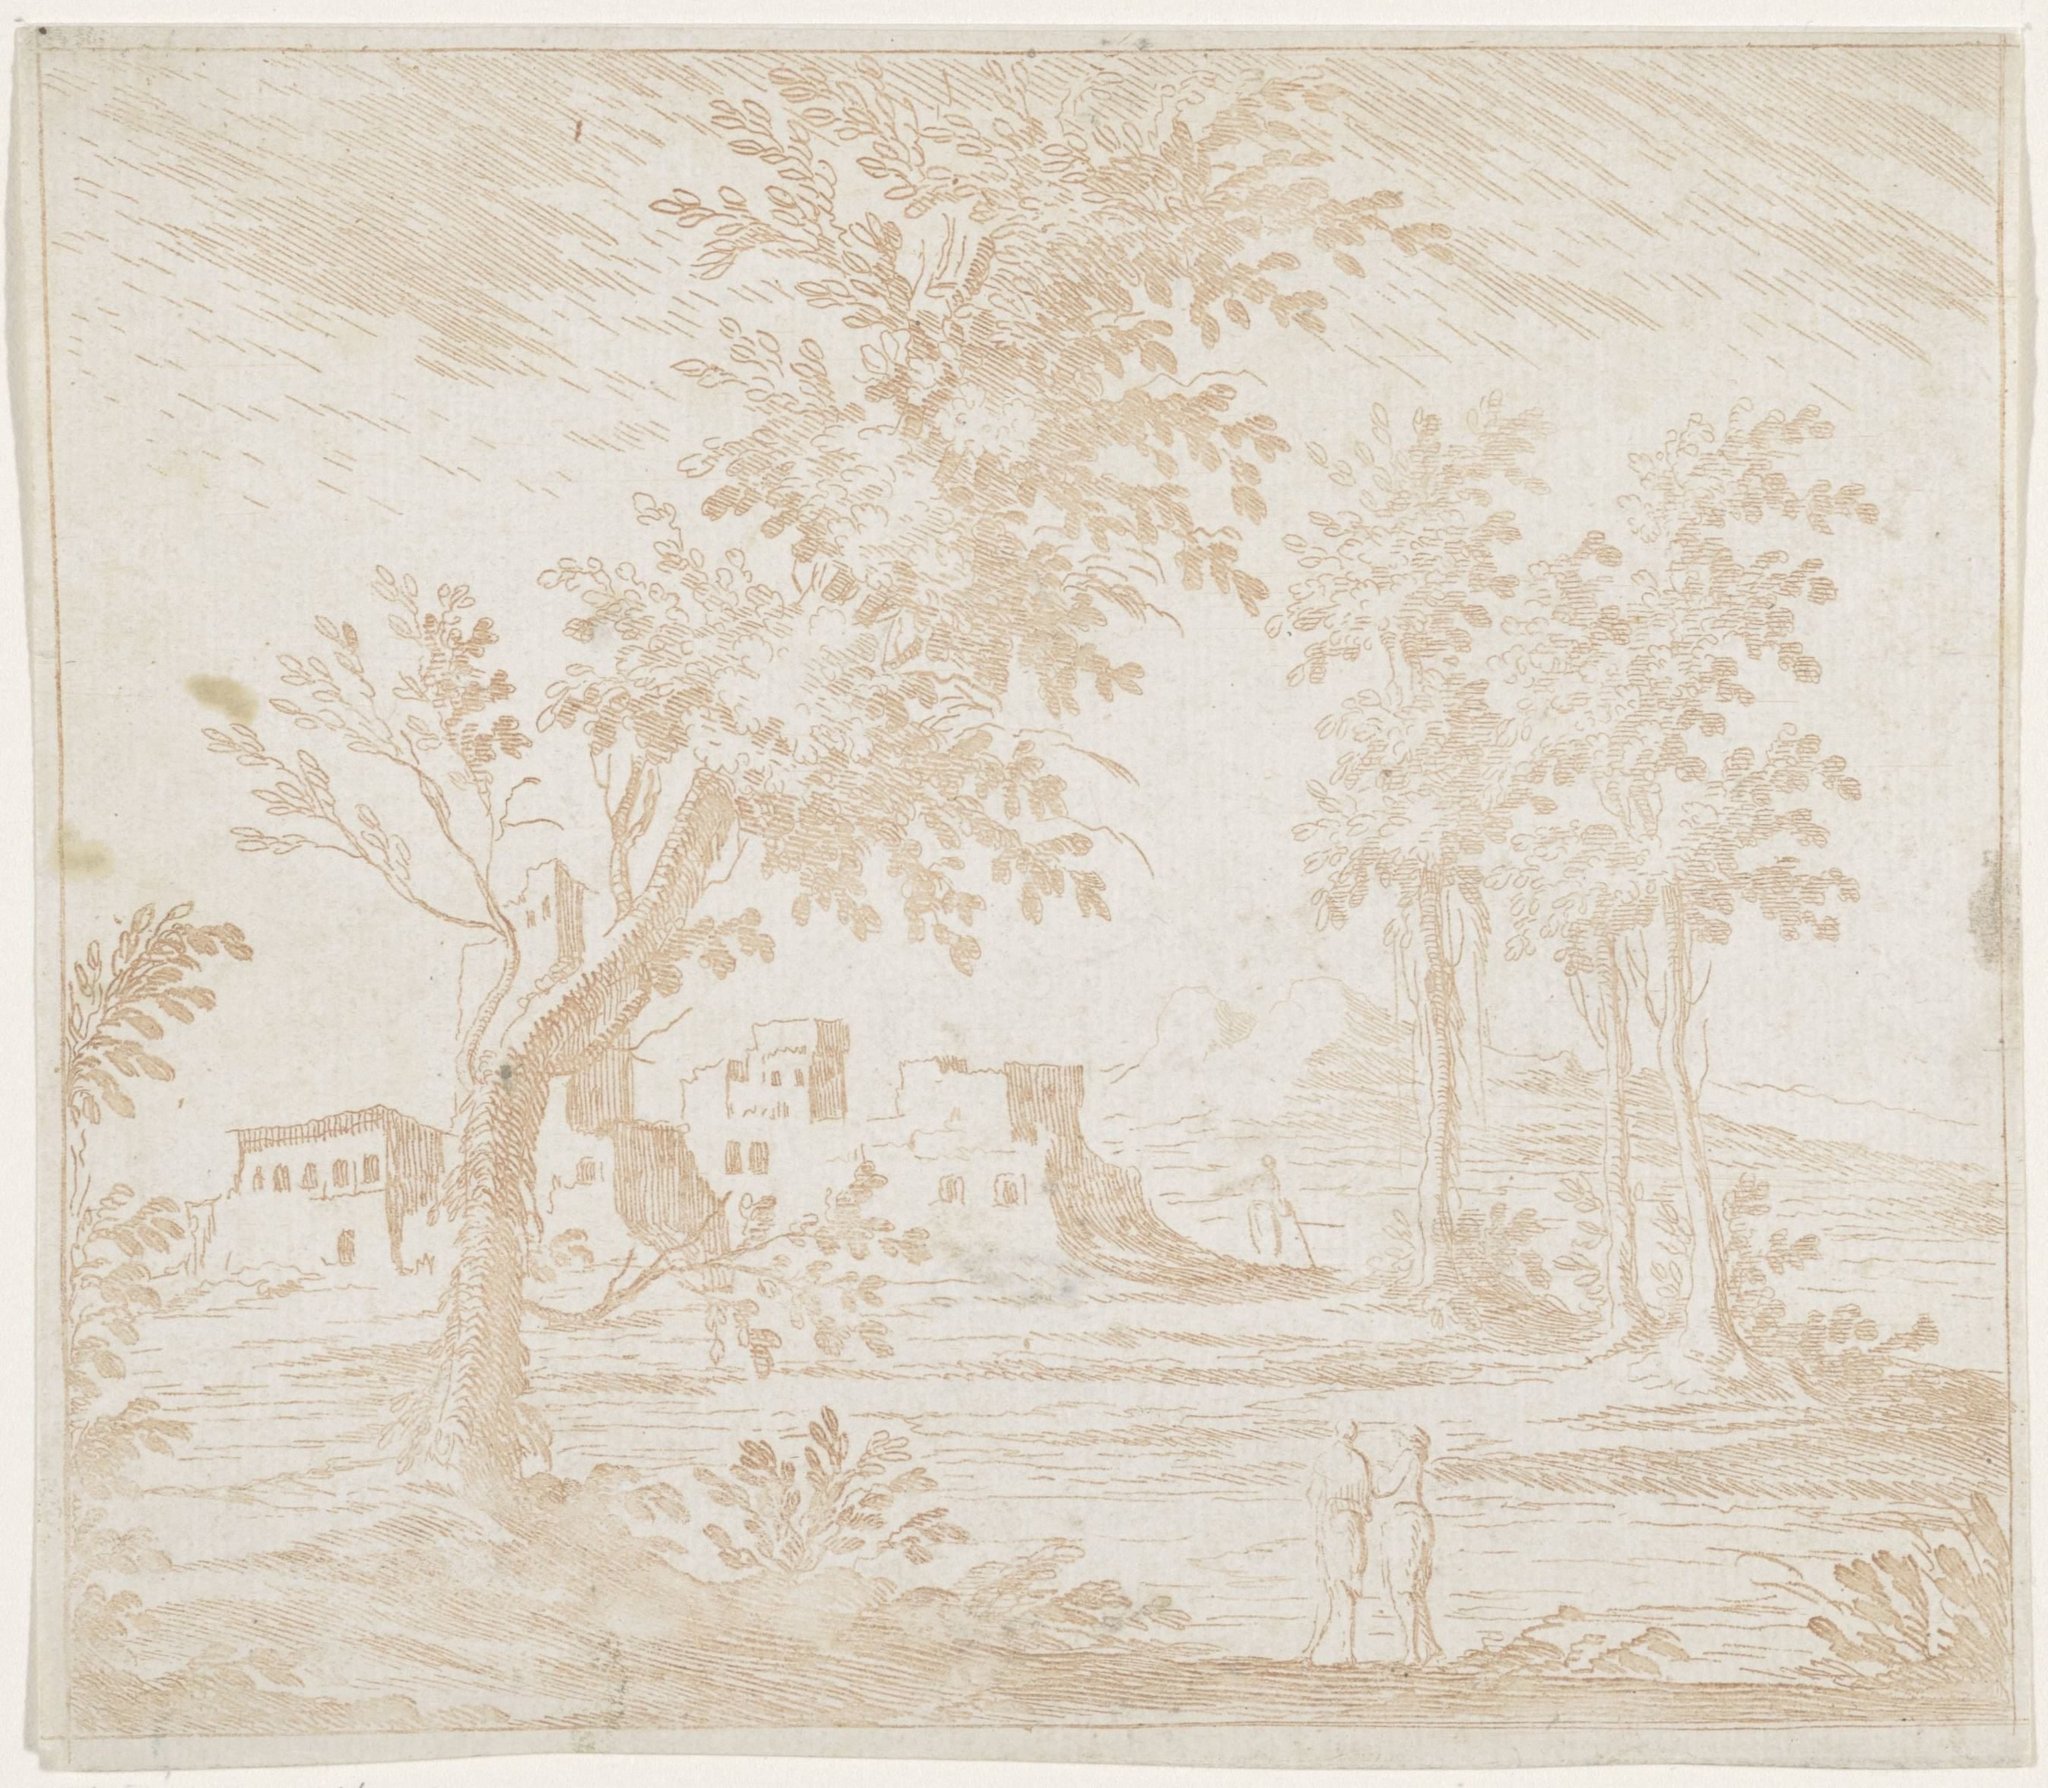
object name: print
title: Landschap met ruïne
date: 1672-1747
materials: paper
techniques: etching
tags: landscape with ruins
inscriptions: collector's mark: Lugt 2228